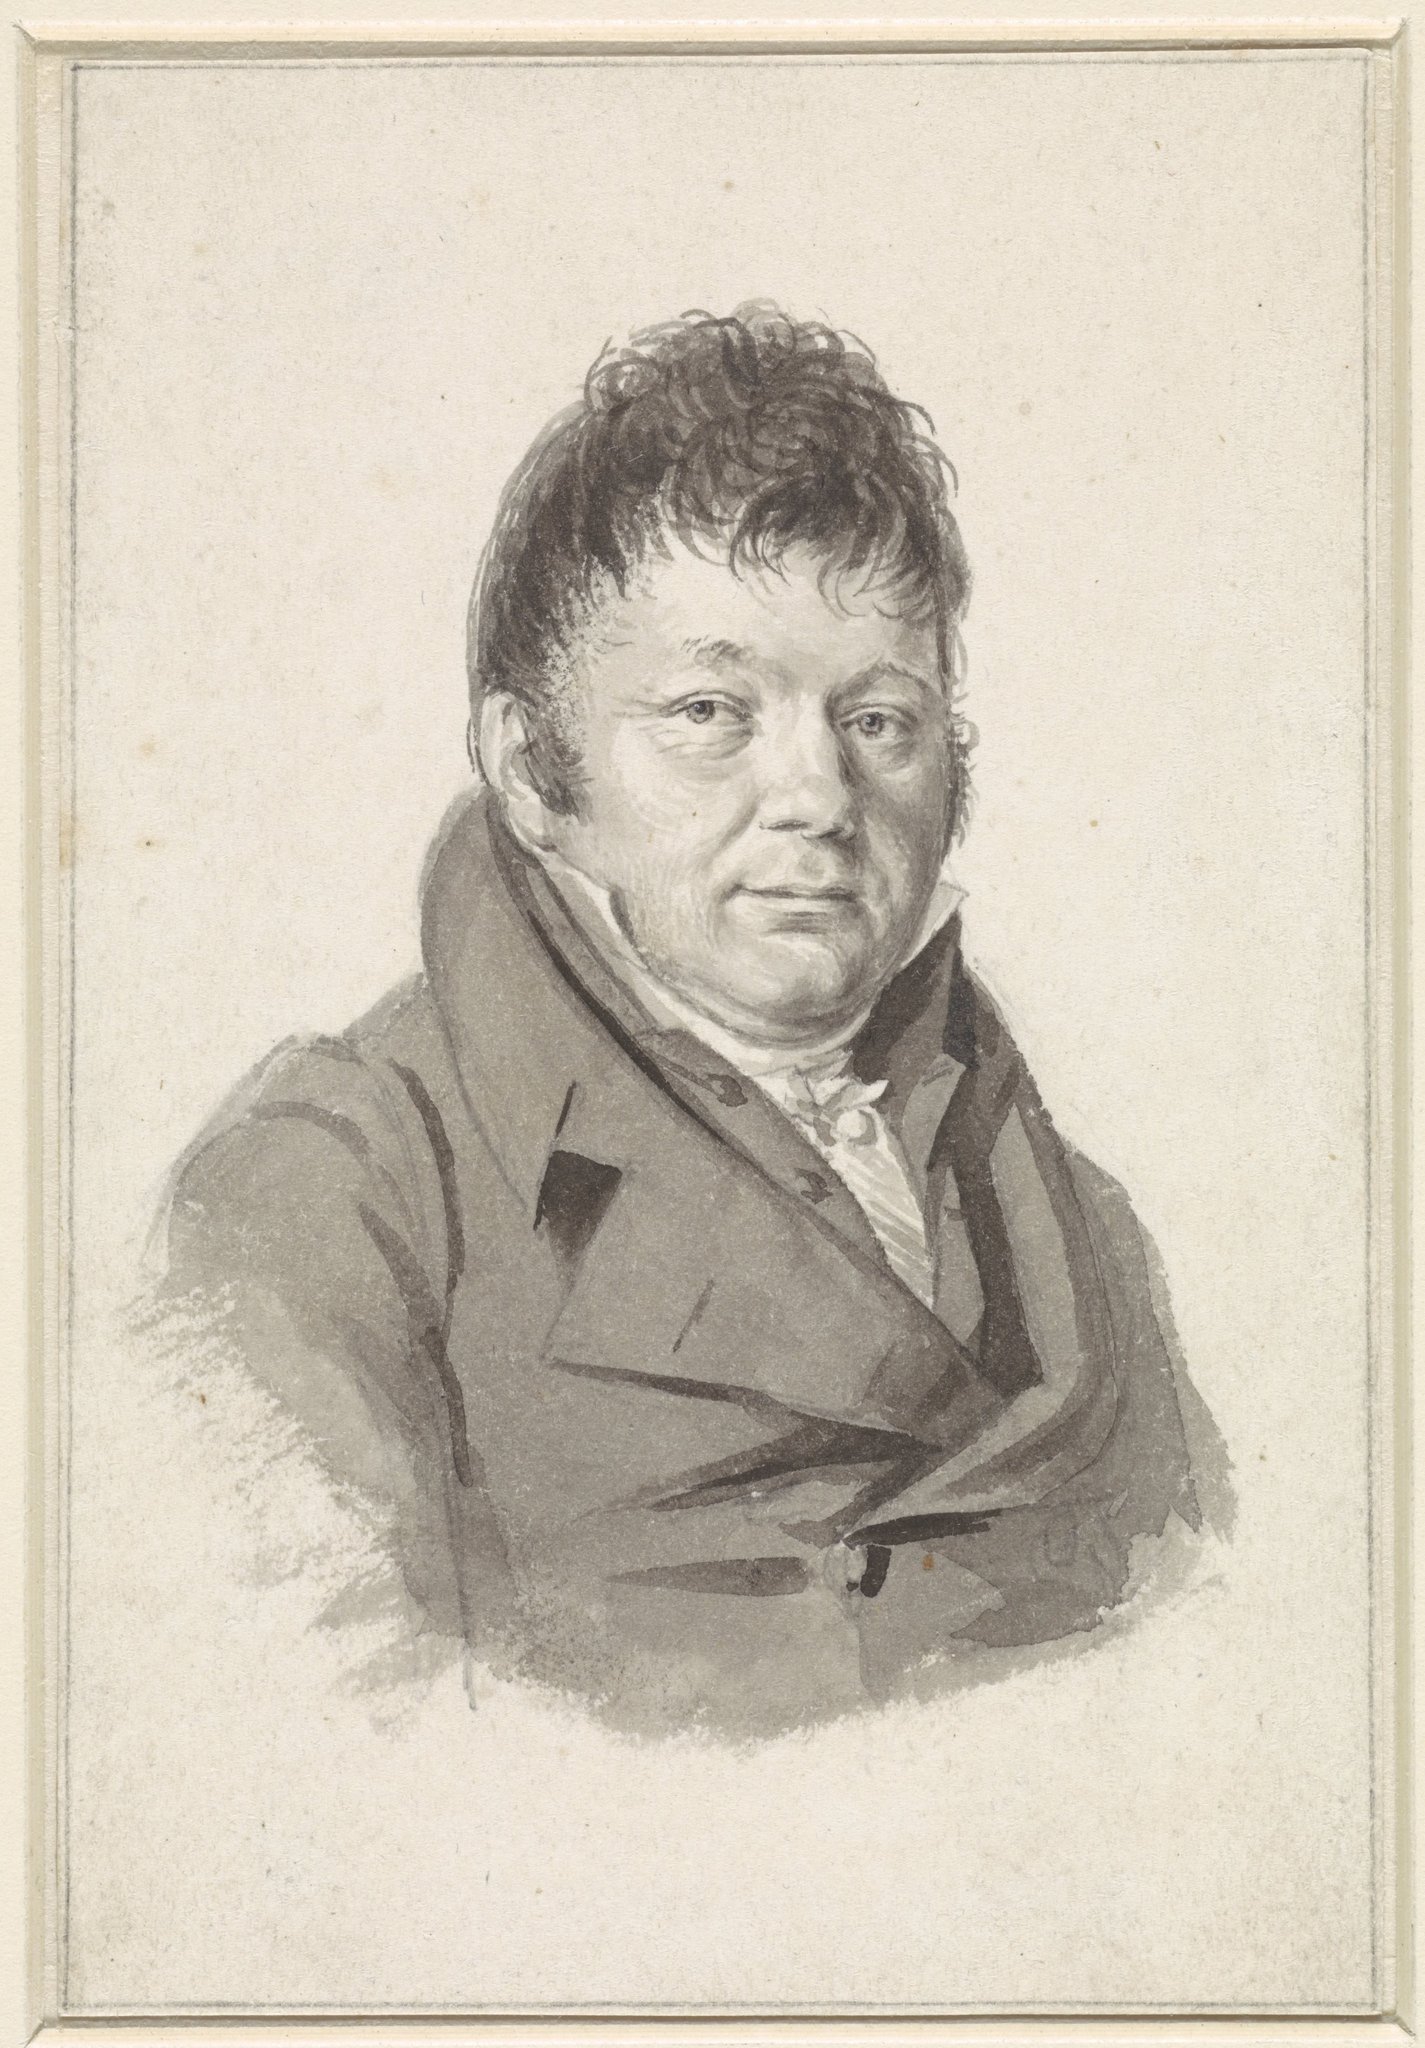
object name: drawing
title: Portret van Carl Joseph Fodor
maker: hendrik willem caspari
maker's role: draughtsman, print maker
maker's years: 1770-1829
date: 1780-1829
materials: paper, watercolor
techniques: brush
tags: amsterdam, carl joseph fodor, historical persons, portrait, self-portrait of painter, portrait, self-portrait of artist, portrait, self-portrait of draughtsman